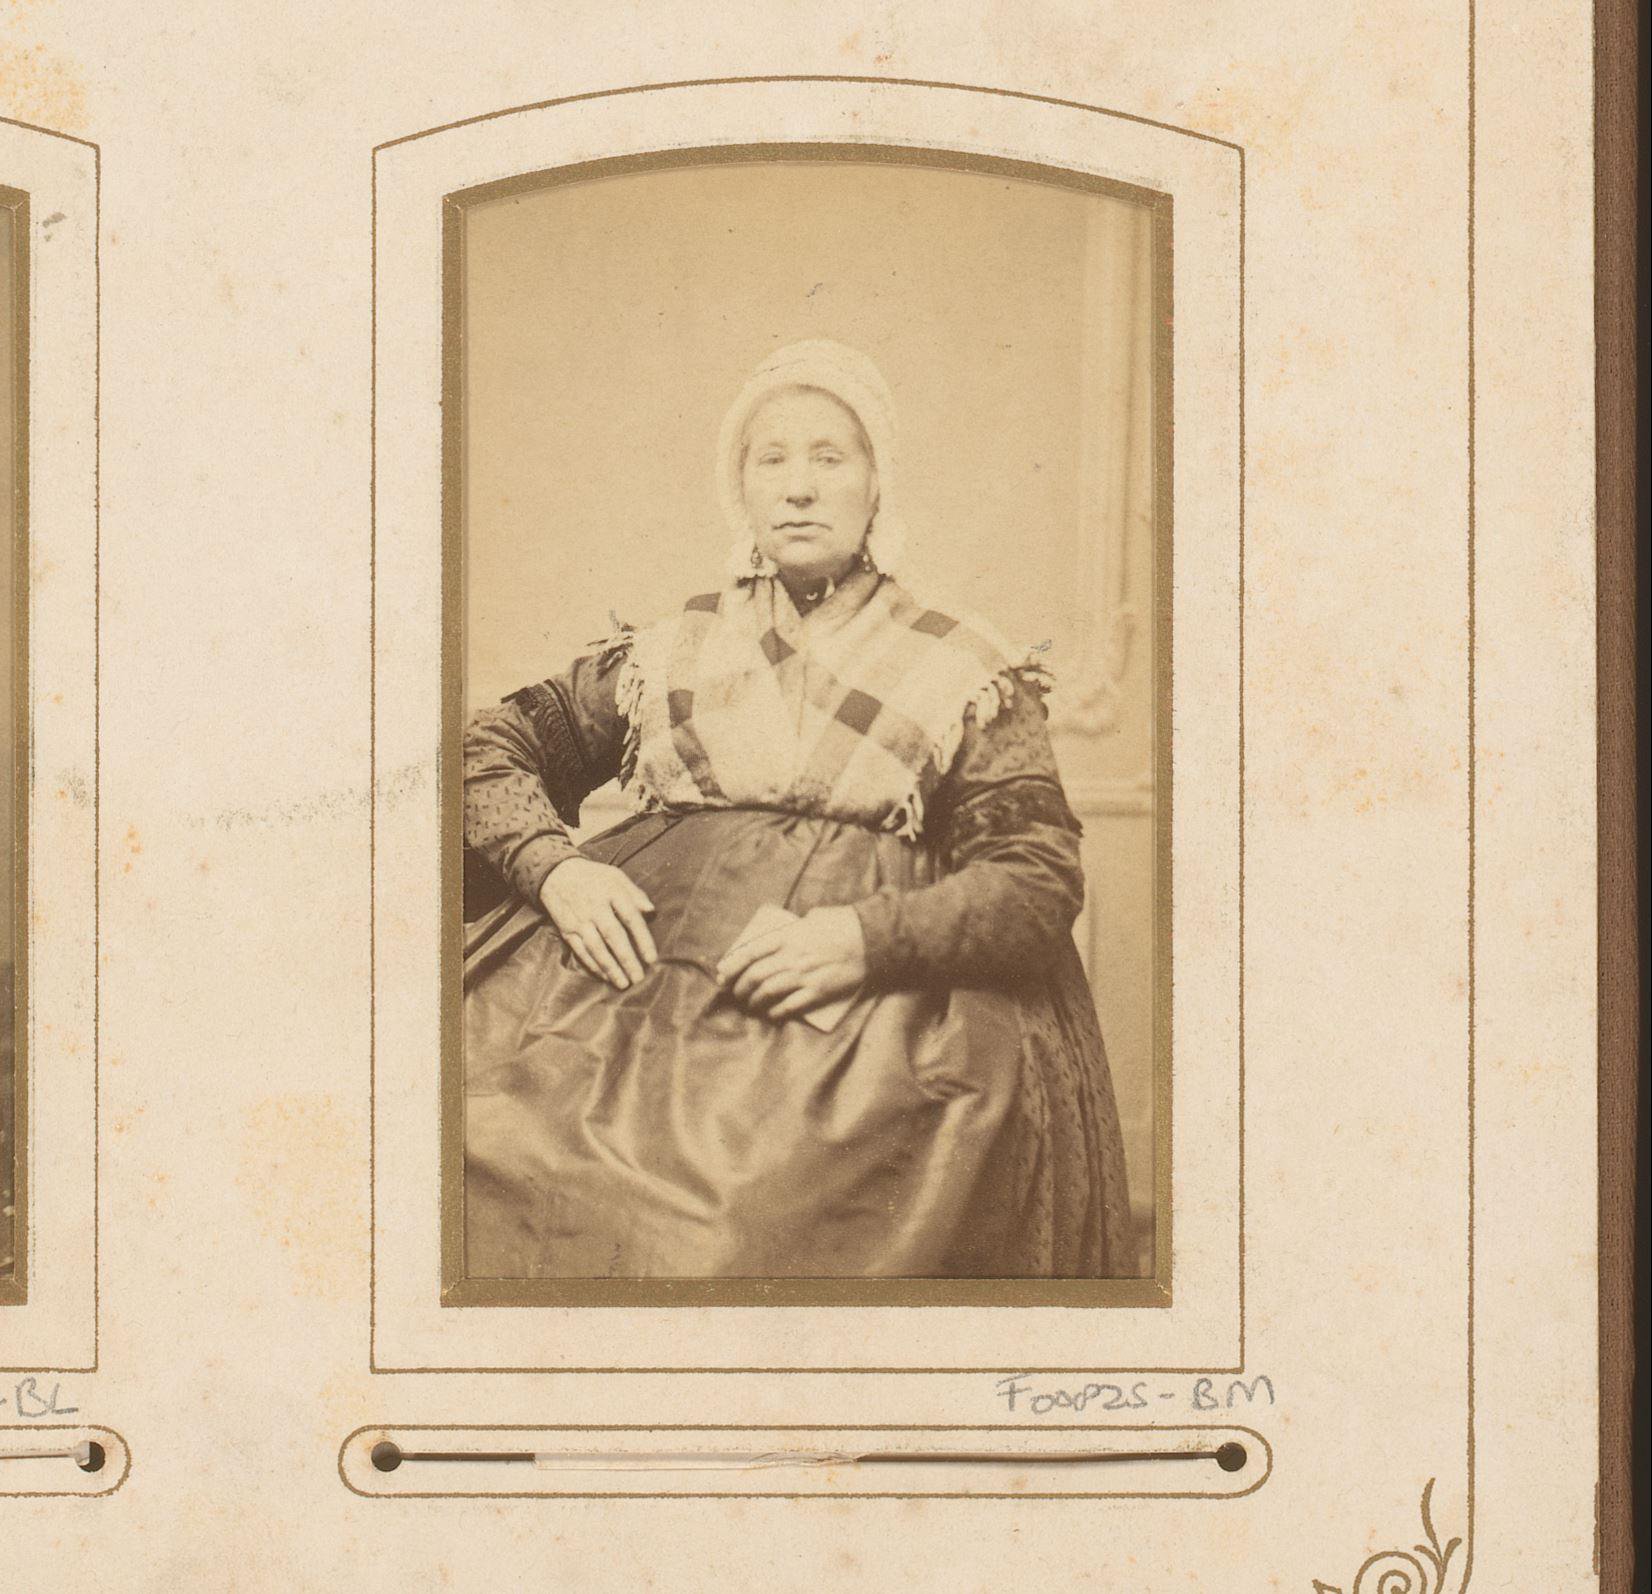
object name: carte de visite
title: Portret van een zittende vrouw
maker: jan george mulder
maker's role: fotograaf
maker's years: 1816-1895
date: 1865-1887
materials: cardboard, photographic support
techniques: albumen print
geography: haarlem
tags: sitting figure - aa - female human figure, historical persons - bb - woman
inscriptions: inscription: ‘Photographisch/ Atelier/ van/ J. G. Mulder./ Lange Bagijnestraat/ Haarlem./ De plaat blijft tot nabestelling bewaard.’